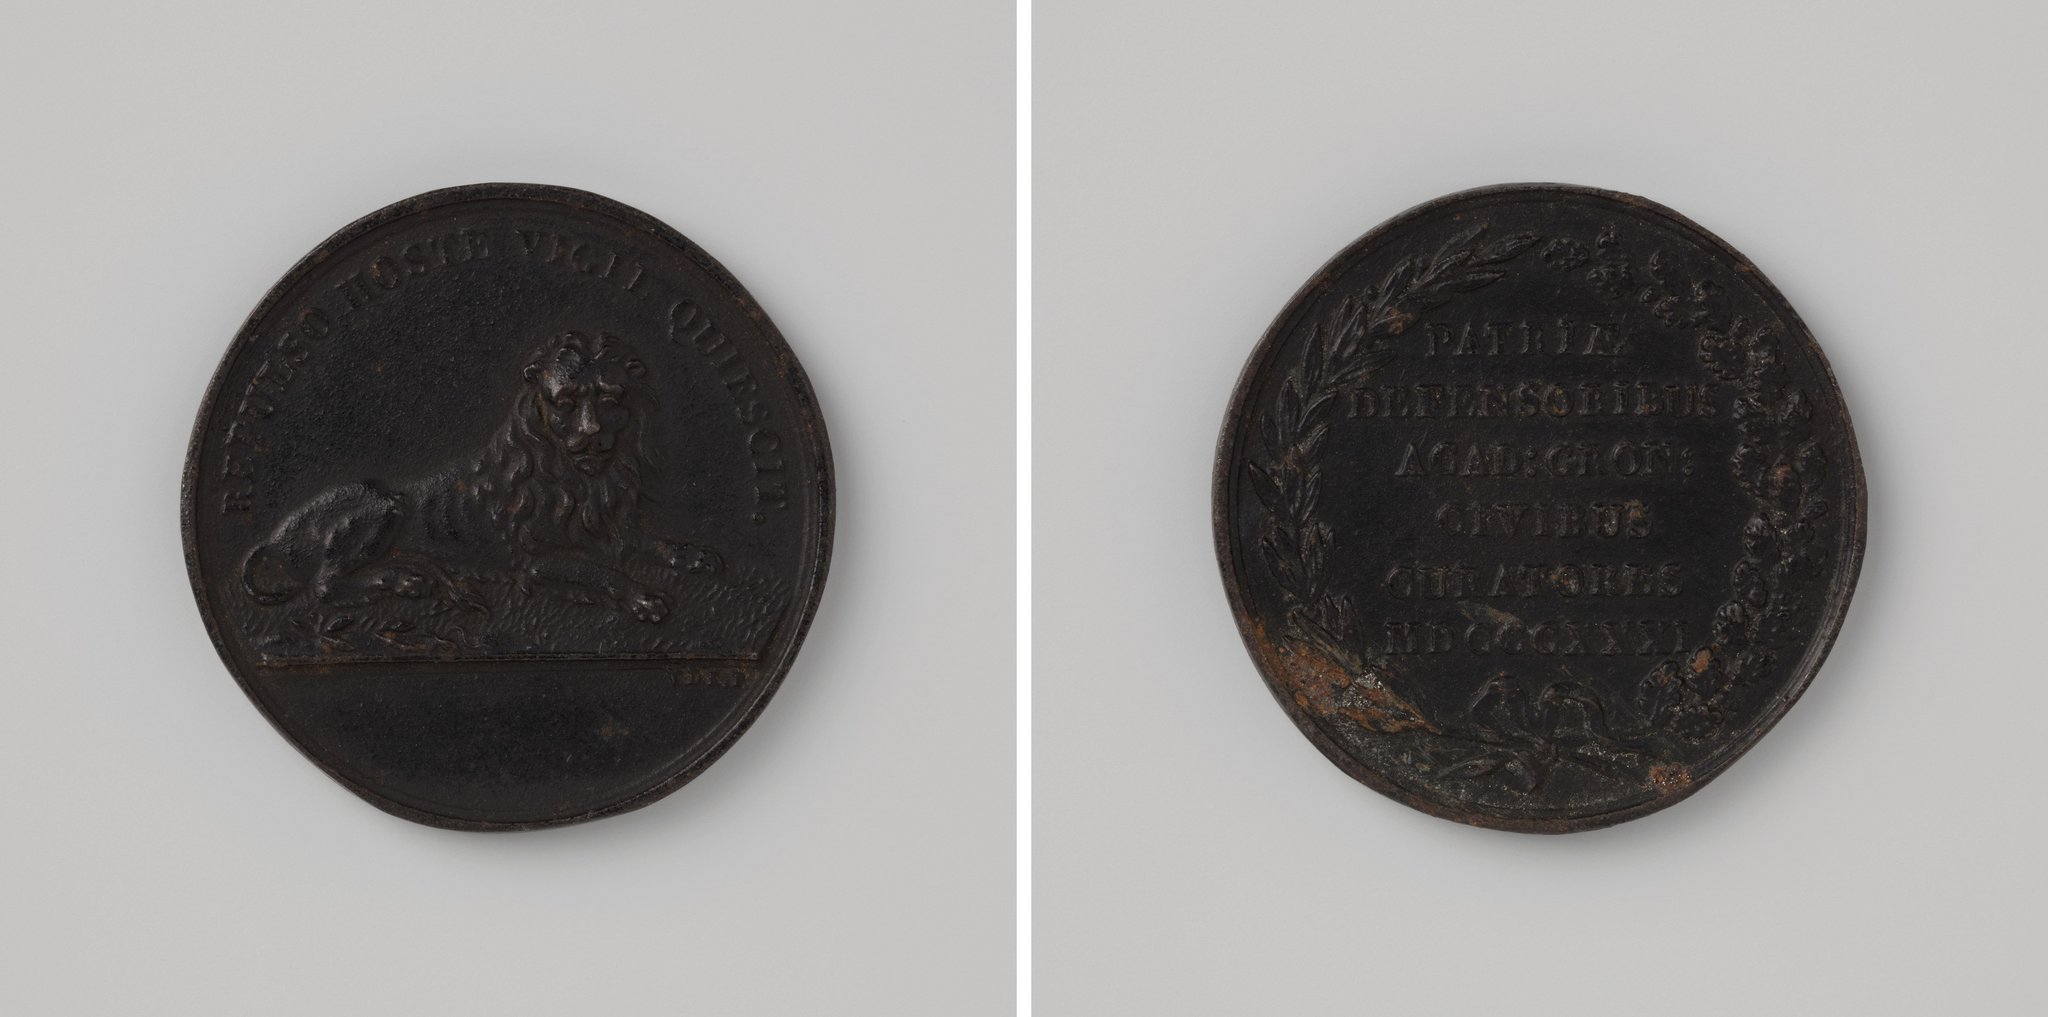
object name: history medal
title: Beloning van de Groninger studenten, uitgetrokken op veldtocht tegen België, door curatoren van de Hogeschool Groningen 1831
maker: david van der kellen (1804-1879)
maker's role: die cutter, draughtsman, print maker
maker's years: 1804-1879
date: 1831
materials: iron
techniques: casting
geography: utrecht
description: IJzeren afgetsel van een penning, op de voorzijde een rustende leeuw naar rechts, met omschrift, op de keerzijde zes regels tekst tussen samengestrikte lauwer- en eikenkransen.